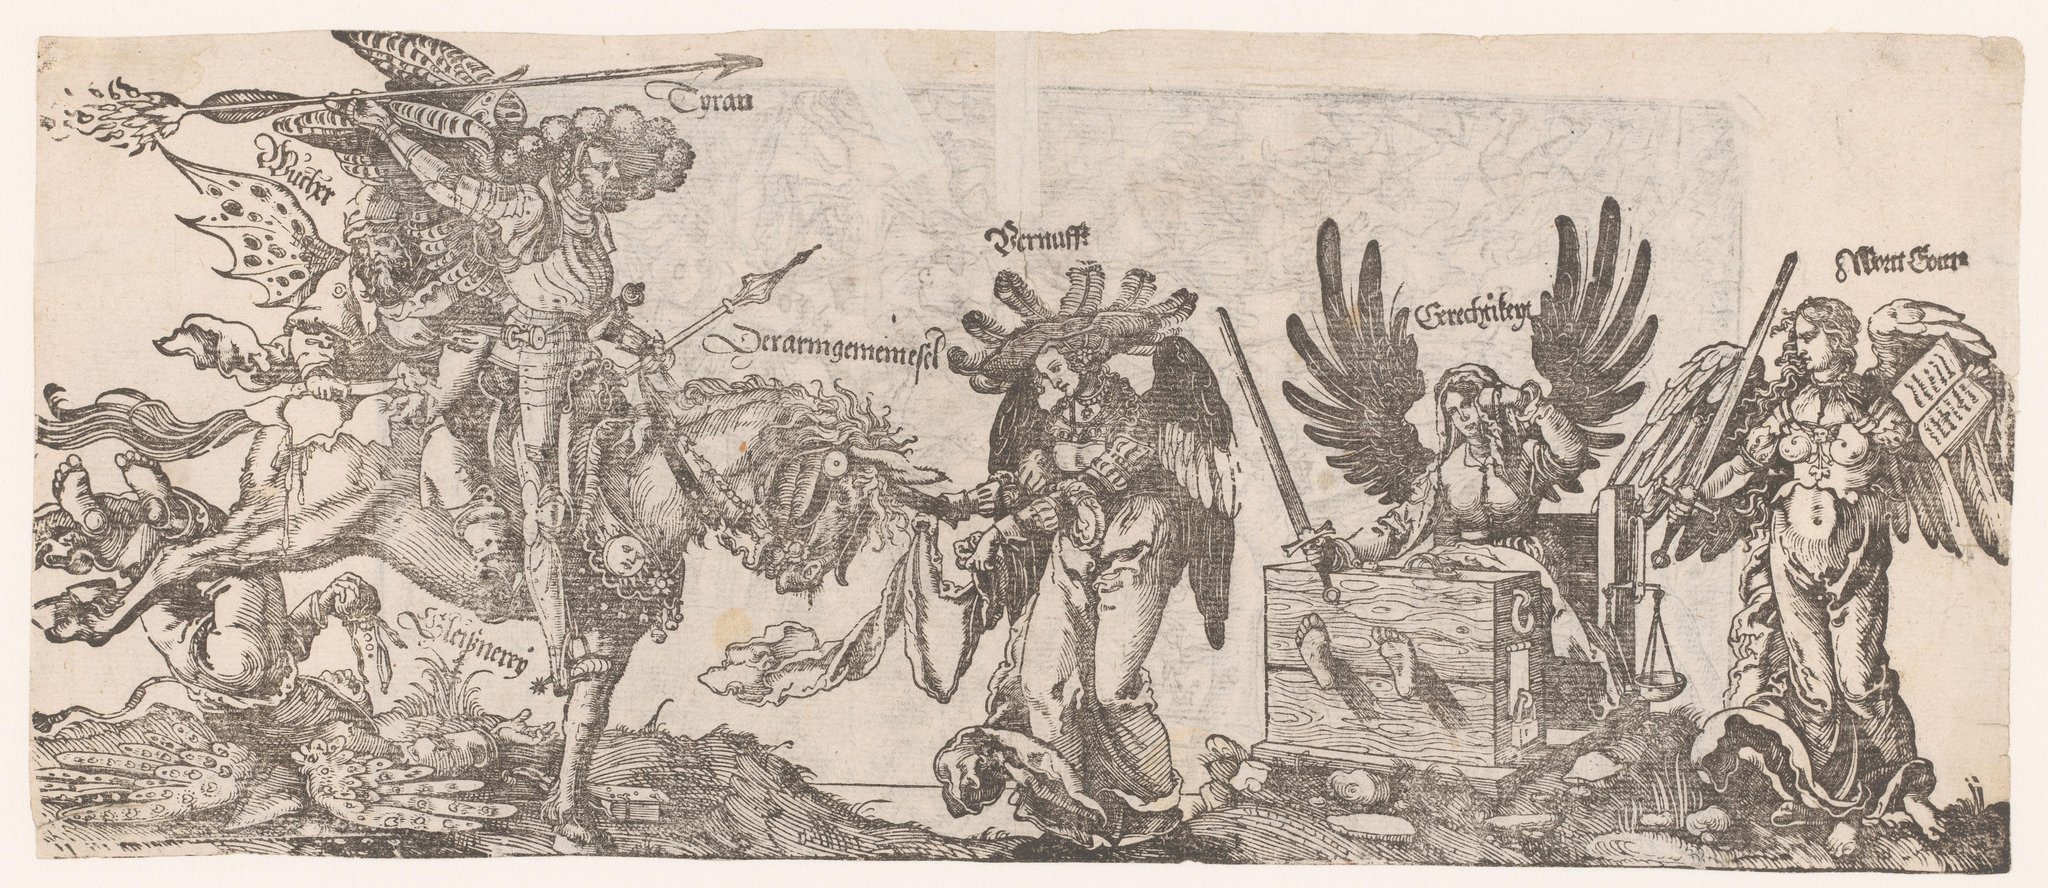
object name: print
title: Allegorie met strijd van Tirannie, Woeker en Hypocrisie tegen Verstand, Gerechtigheid en het Woord Gods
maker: peter flötner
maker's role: print maker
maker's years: 1485-1546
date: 1525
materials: paper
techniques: woodcut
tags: abstract ideas and concepts (+ allegorical scene, i.e. two or more personifications involved in an action)